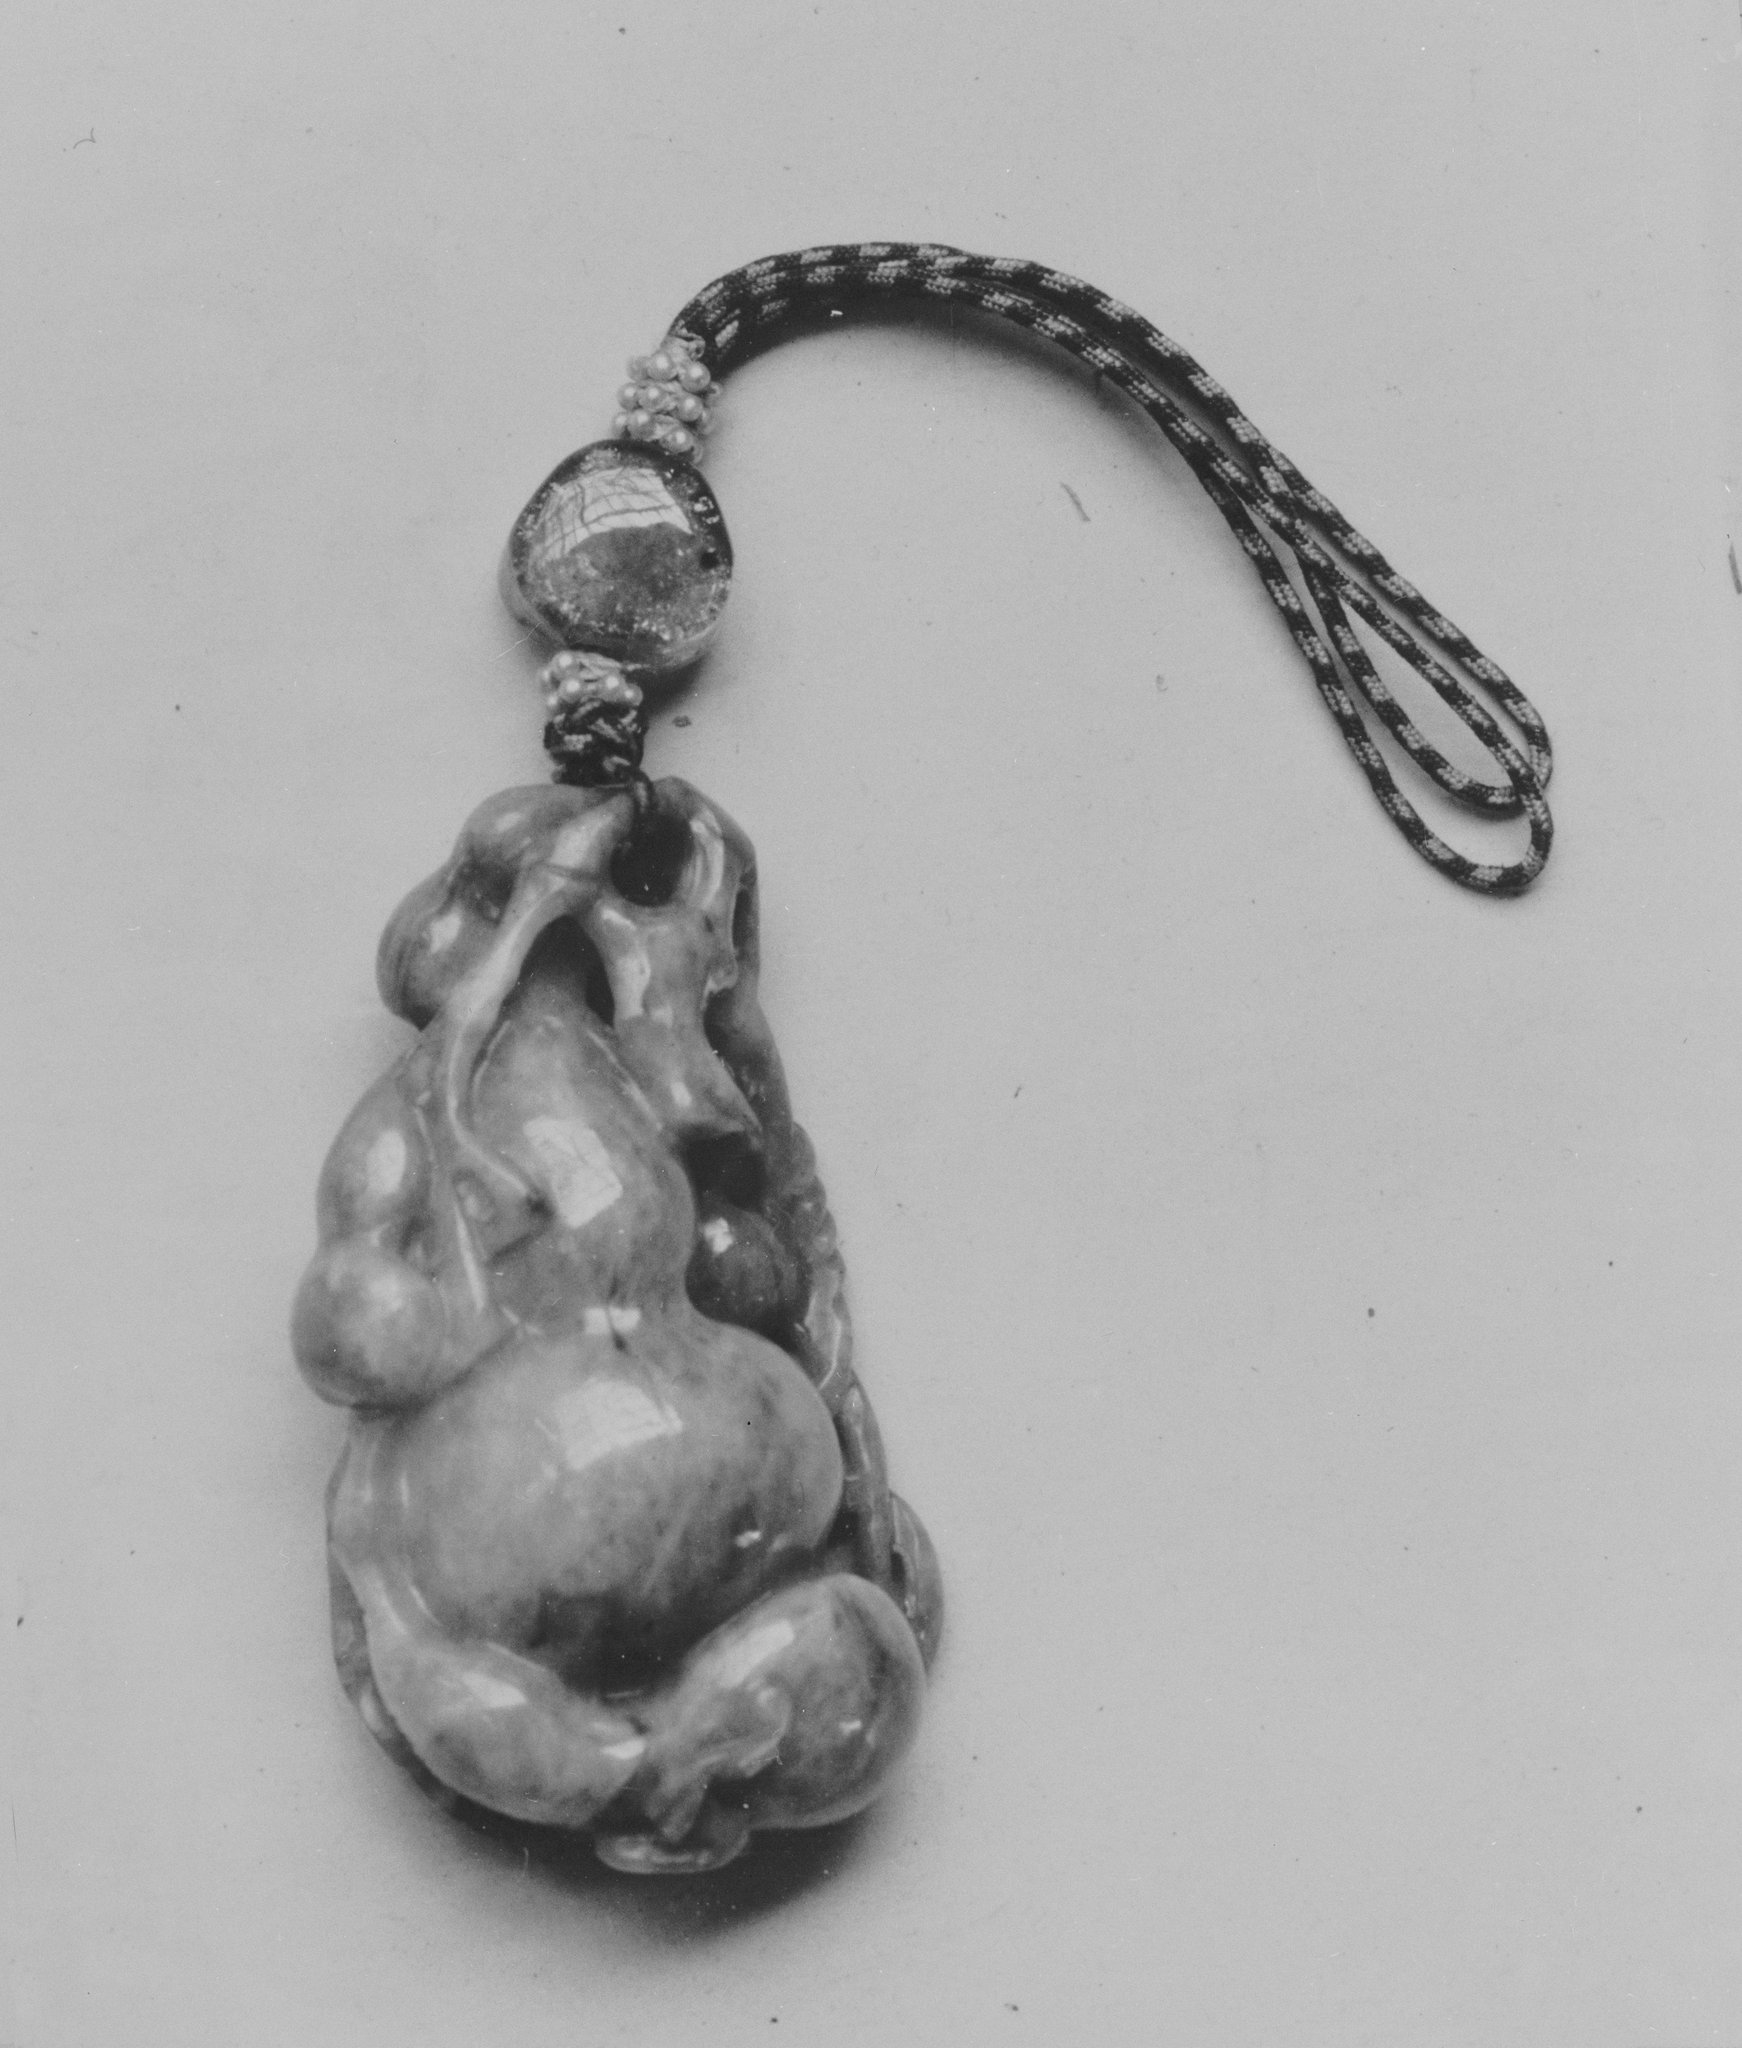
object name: ornament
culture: chinese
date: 1801-1900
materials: jade